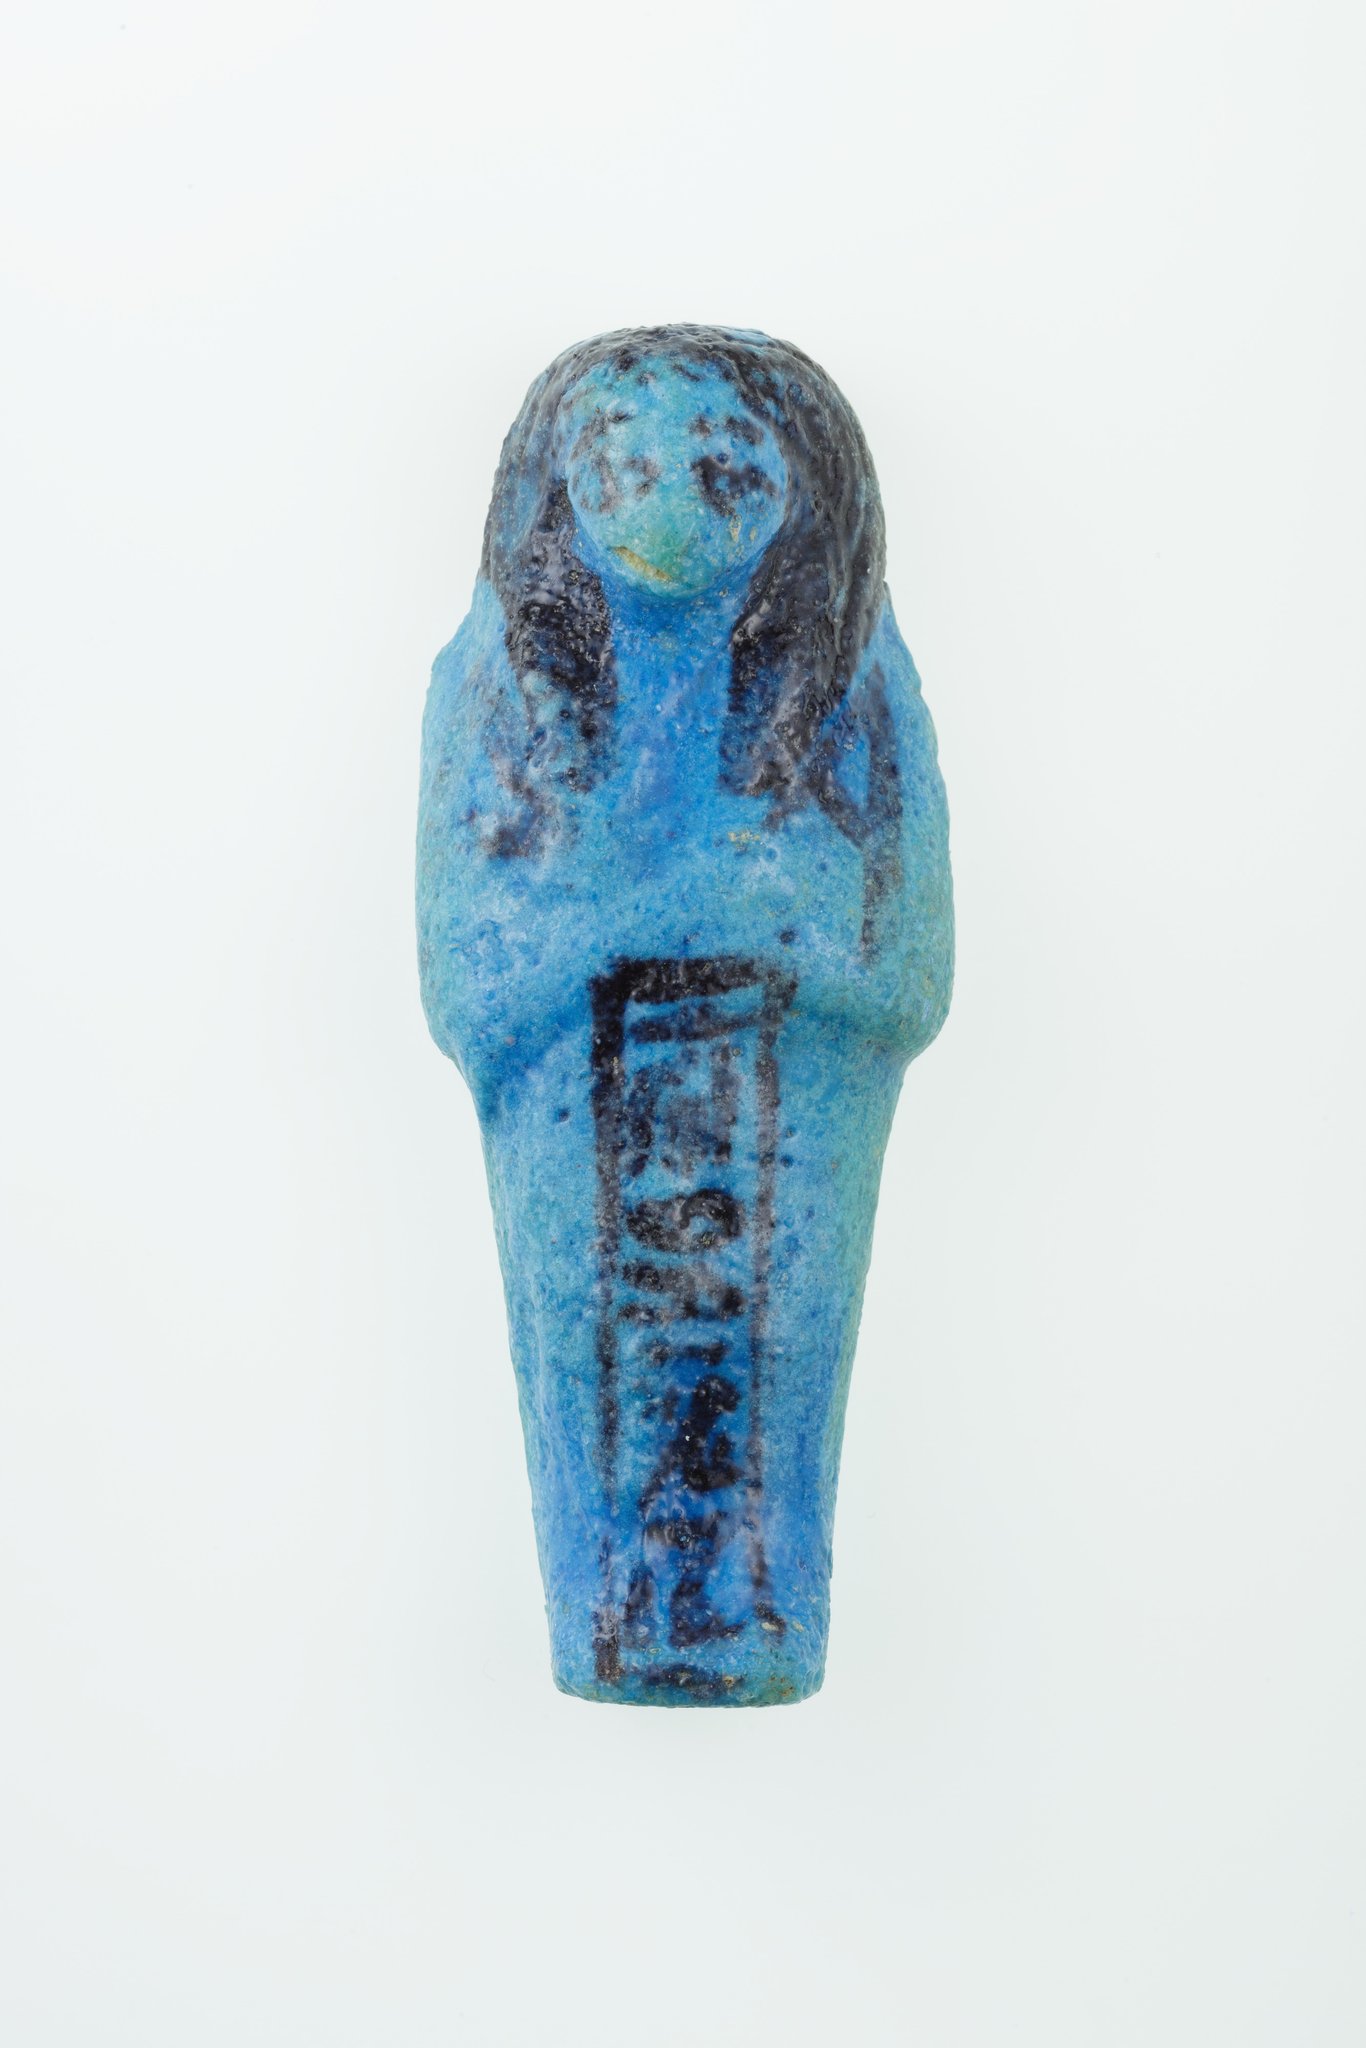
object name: shabti, worker, nauny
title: Worker Shabti of Nauny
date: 1050 BCE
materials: faience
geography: egypt